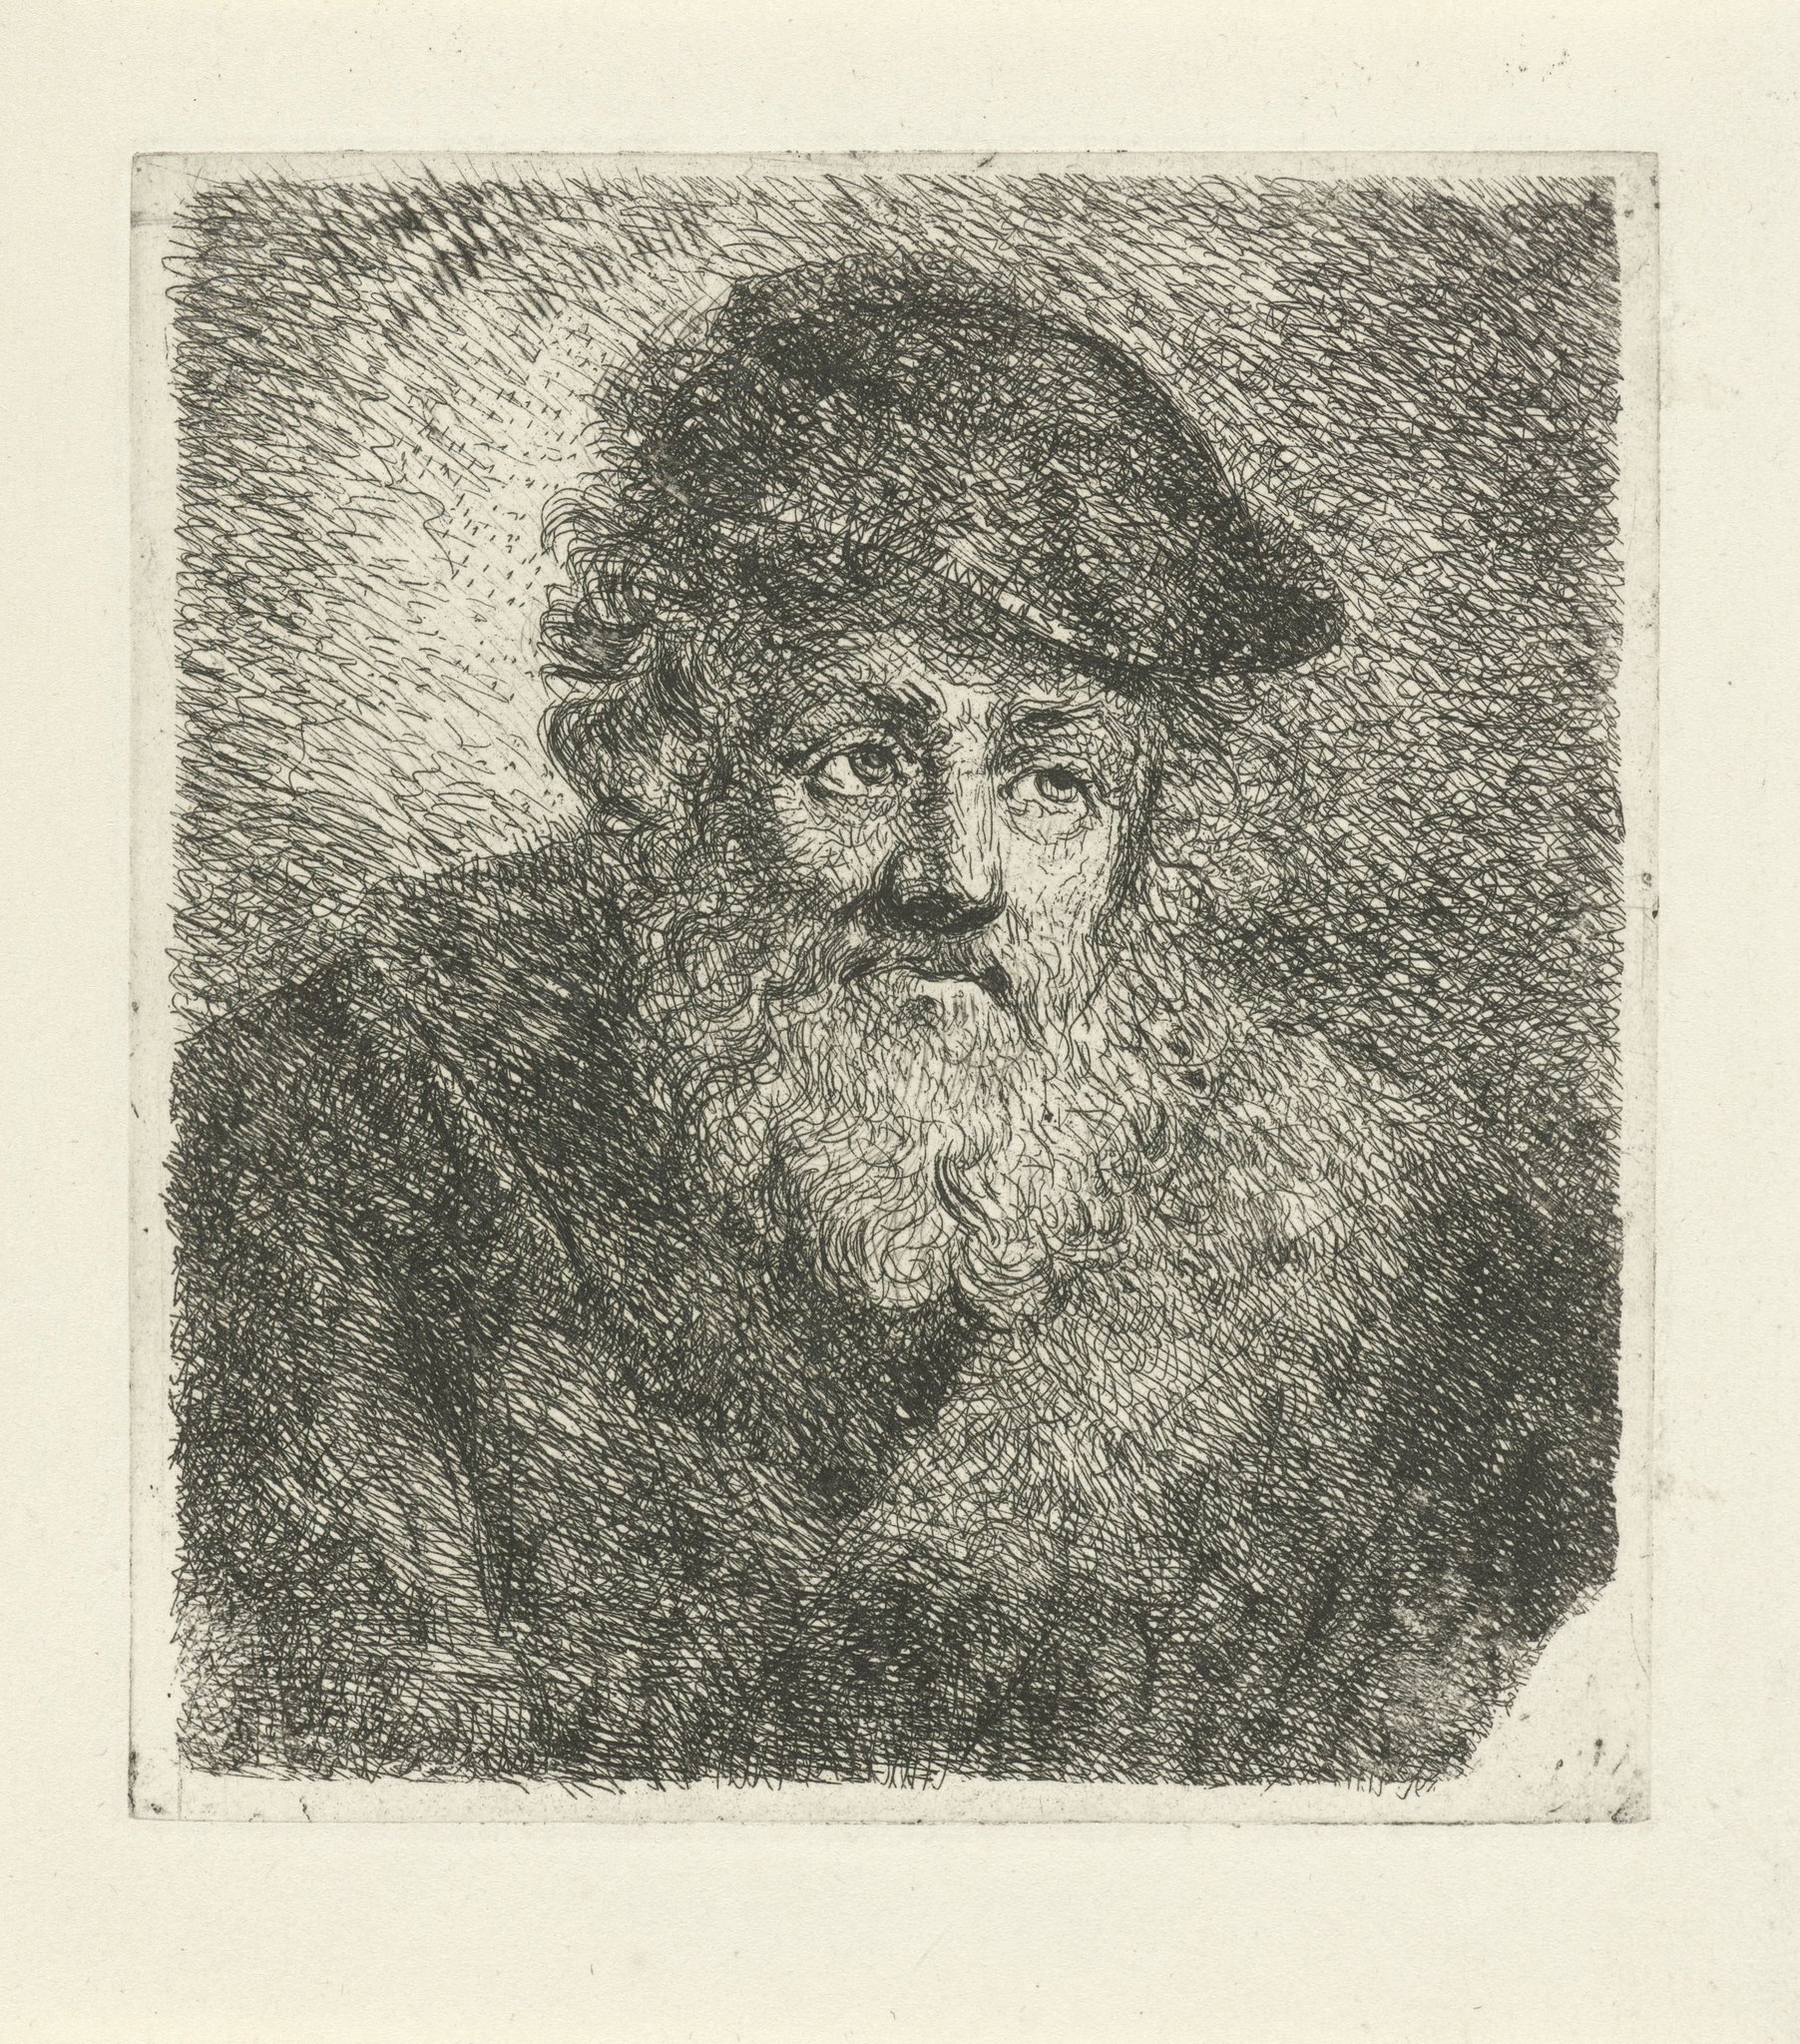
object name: print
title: Kop van een oude man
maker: cornelis johan laarman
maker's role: print maker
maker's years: 1844-1889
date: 1854-1889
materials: paper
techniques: etching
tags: anonymous historical person portrayed alone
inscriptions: collector's mark: Lugt 2228